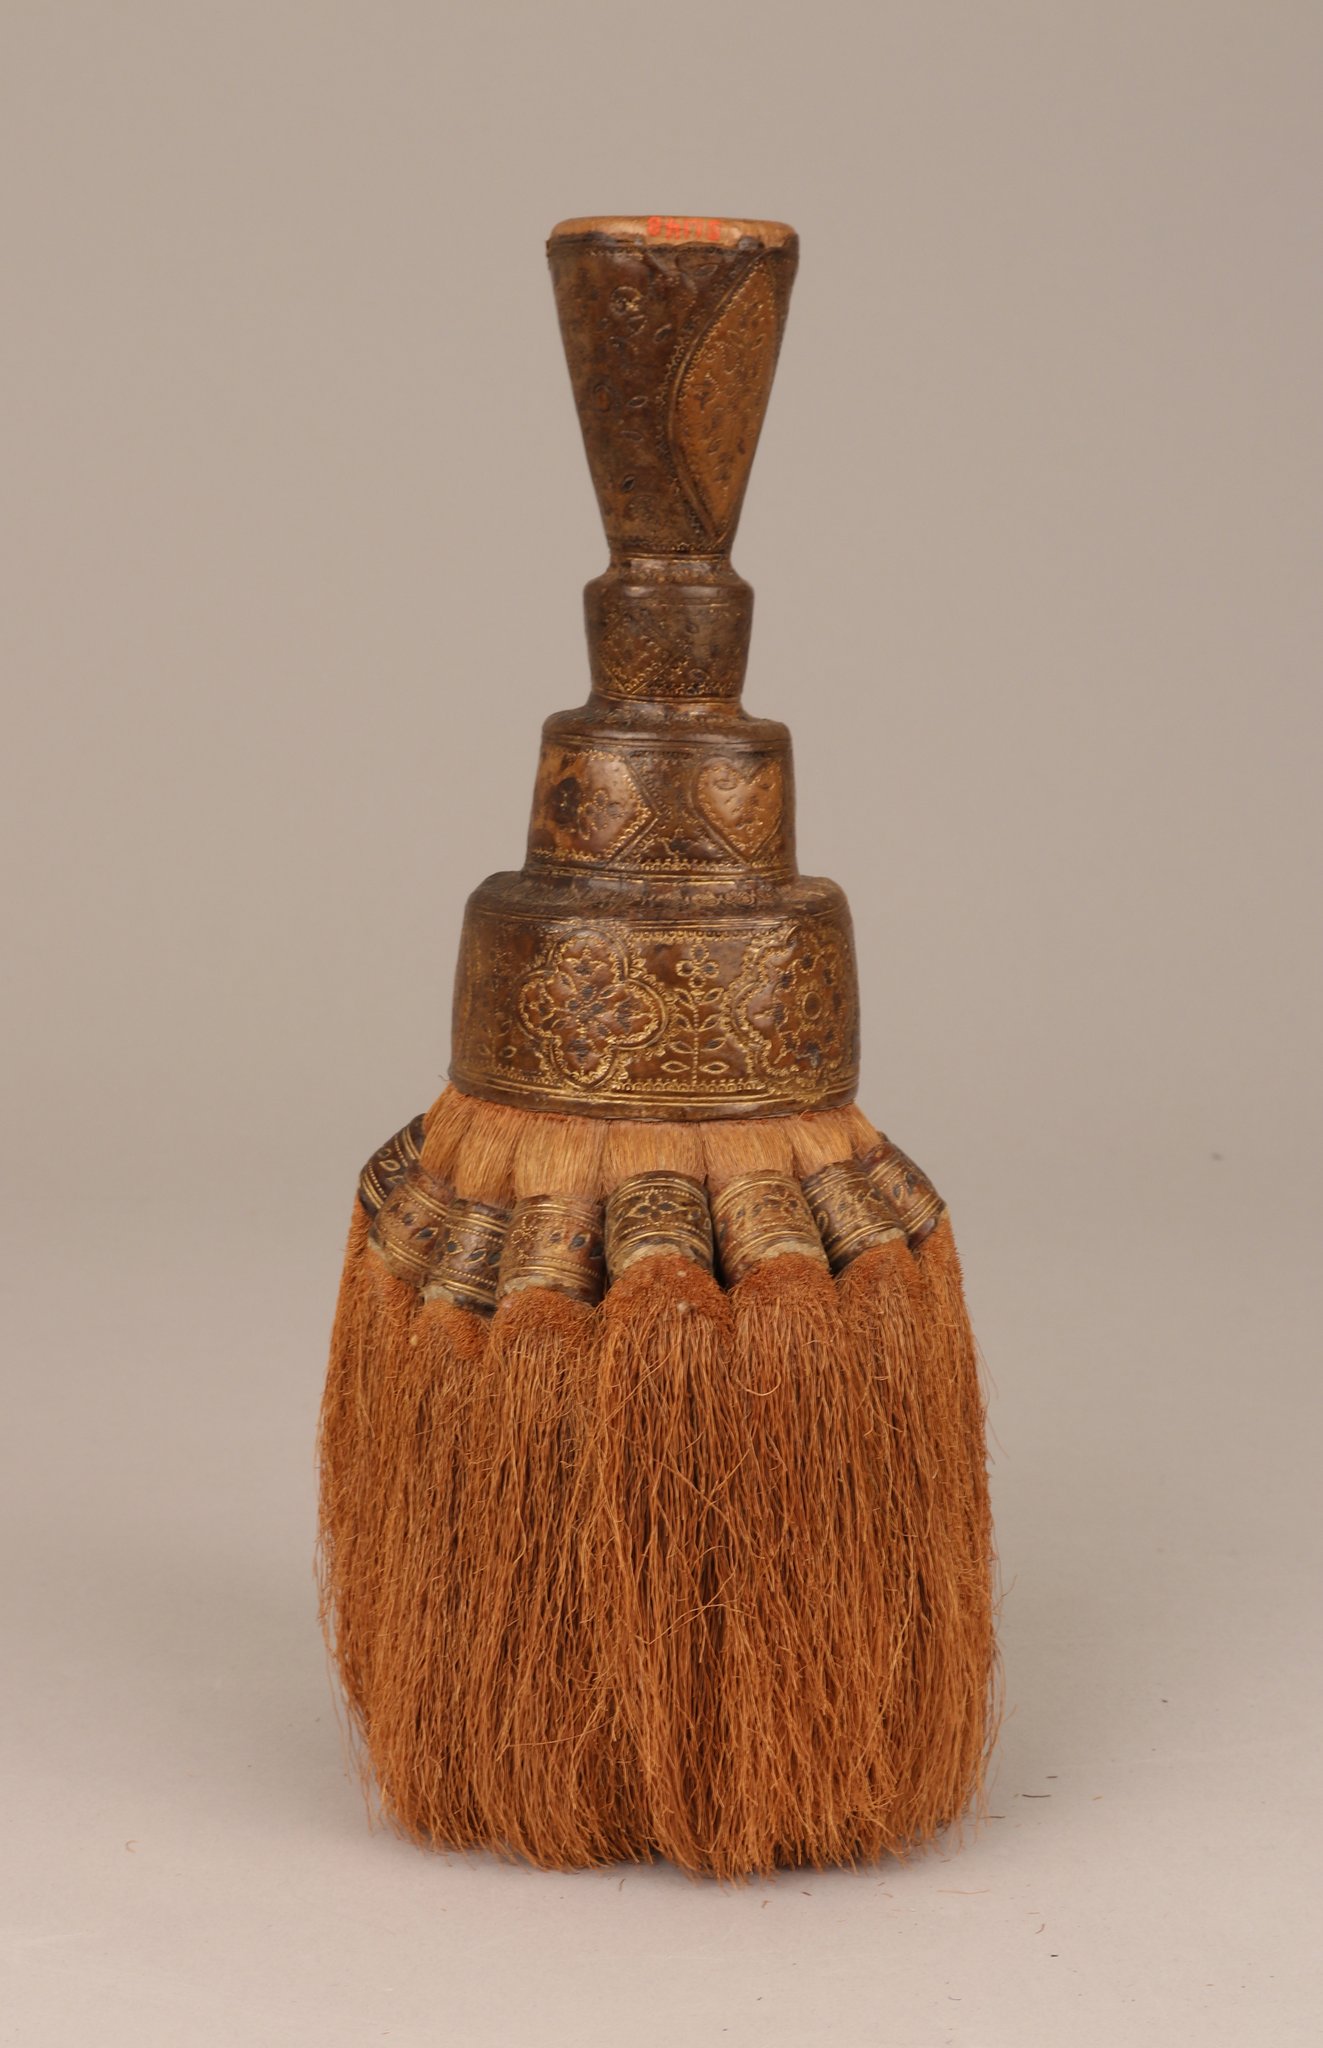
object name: brush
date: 1501-1600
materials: leather, wood